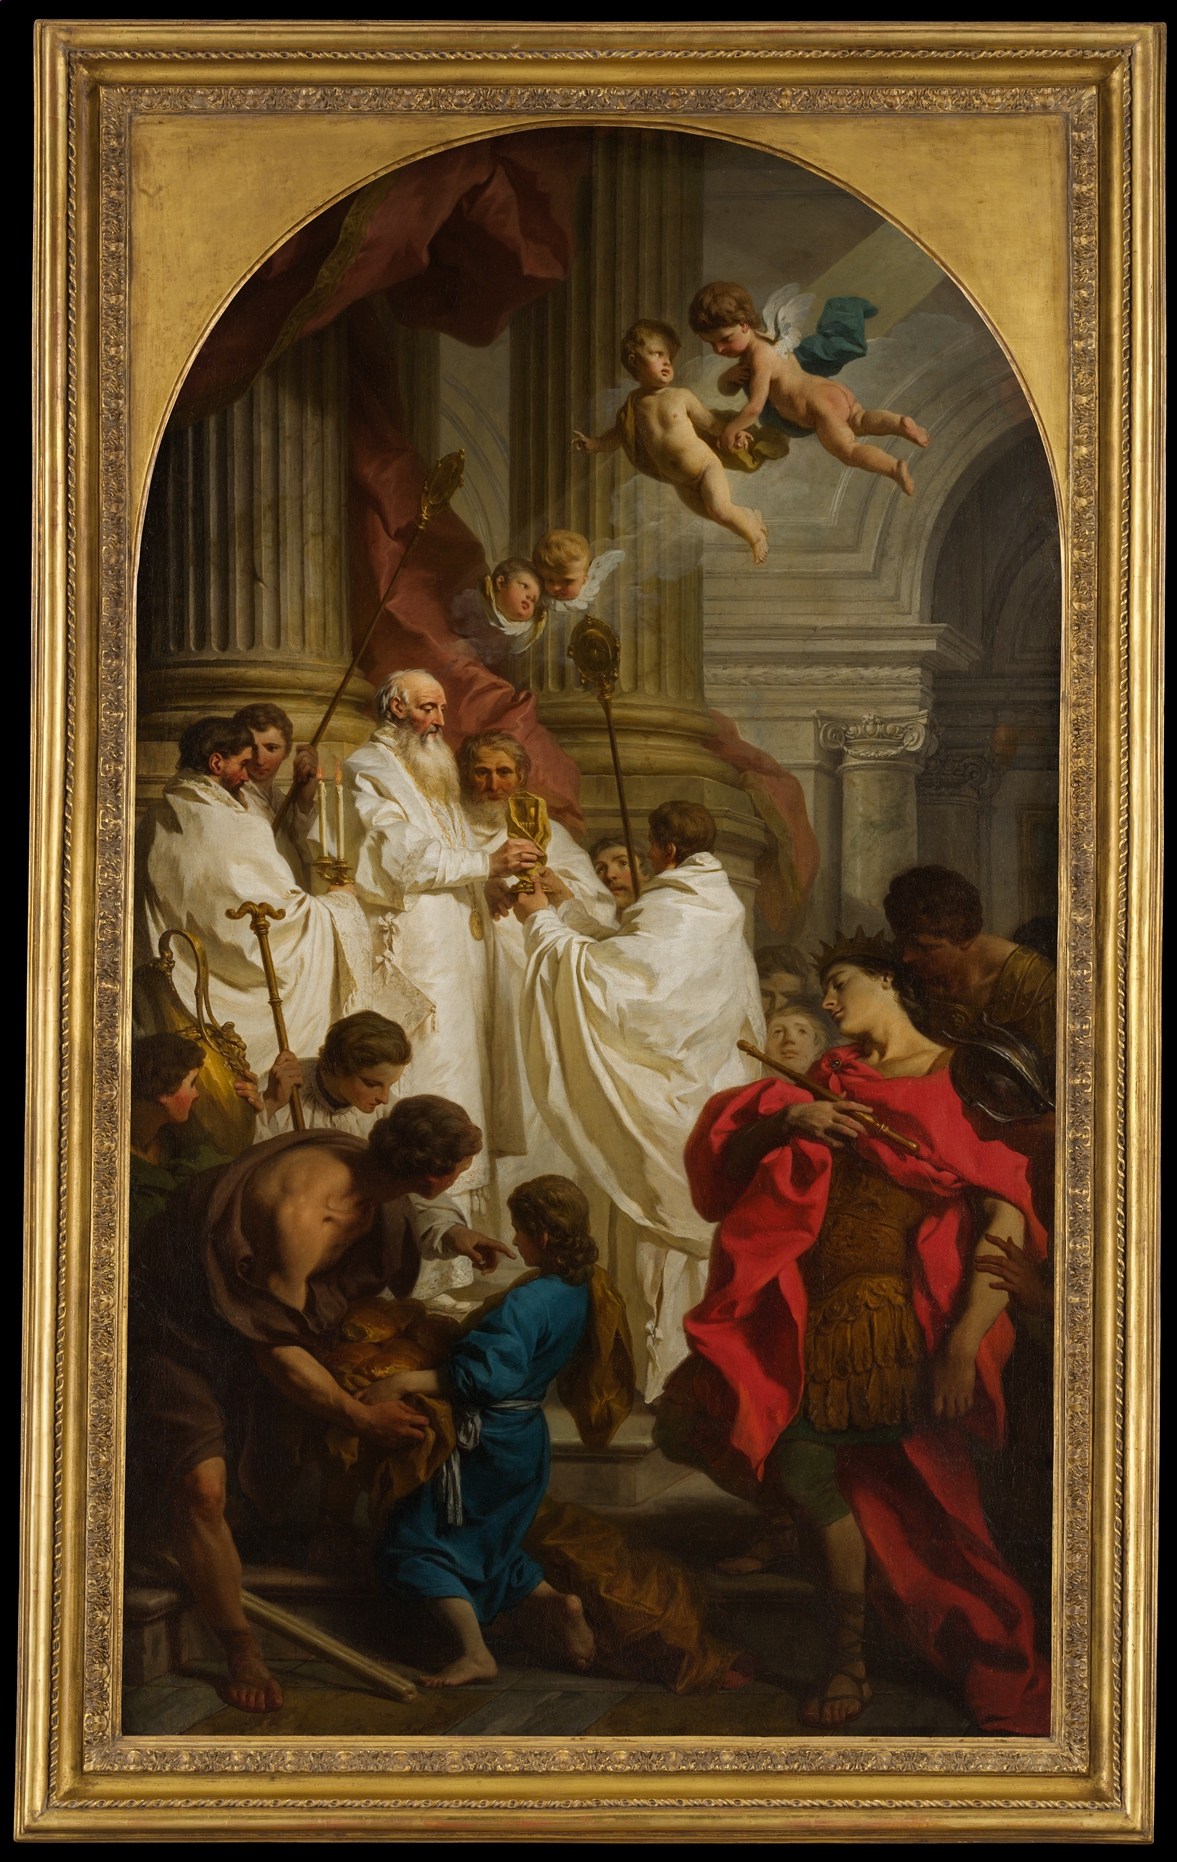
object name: painting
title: The Mass of Saint Basil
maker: pierre hubert subleyras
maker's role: artist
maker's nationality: french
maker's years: 1699-1749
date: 1746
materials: canvas, oil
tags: men,women,putti,saints